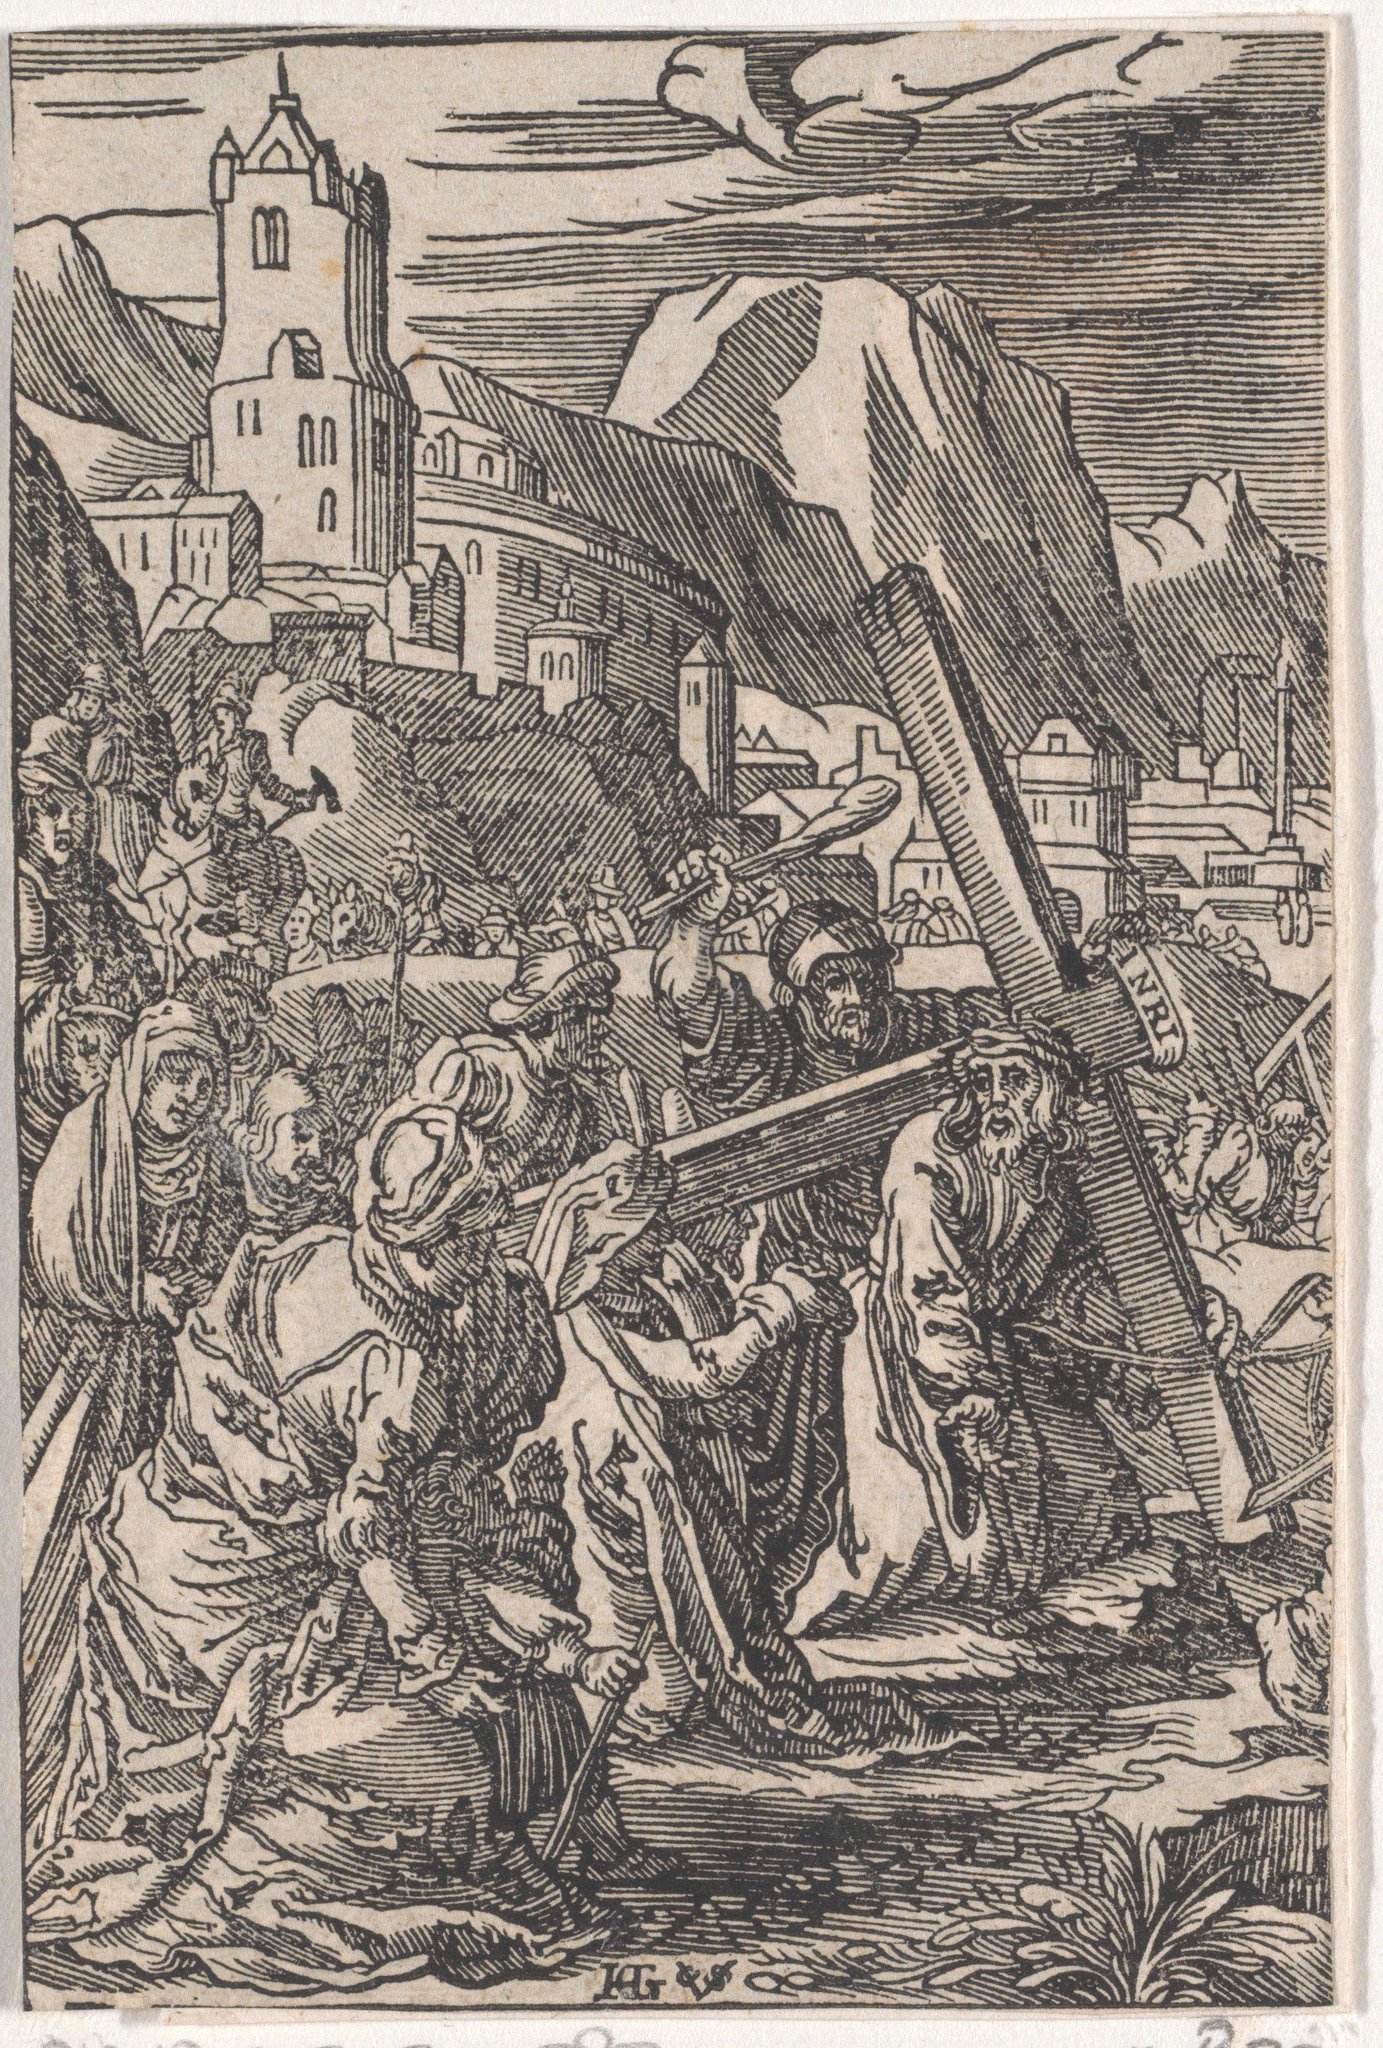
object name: print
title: Kruisdraging van Christus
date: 1648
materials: paper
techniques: woodcut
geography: amsterdam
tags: carrying of the cross: christ bearing the cross, alone or with the help of others (e.g. simon the cyrenian)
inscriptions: collector's mark: Lugt 240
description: Prent uit: Sichem, Christoffel van (II). 'tSchat der zielen, dat is: Het geheele leven ons Heeren Iesu Christi. Amsterdam: Pieter Jacobsz. Paets, 1648. Prent uit: Biblia sacra dat is De geheele Heylighe Schrifture bedeylt in 't Out en Nieu Testament. Amsterdam: Pieter Jacobsz. Paets, 1657.